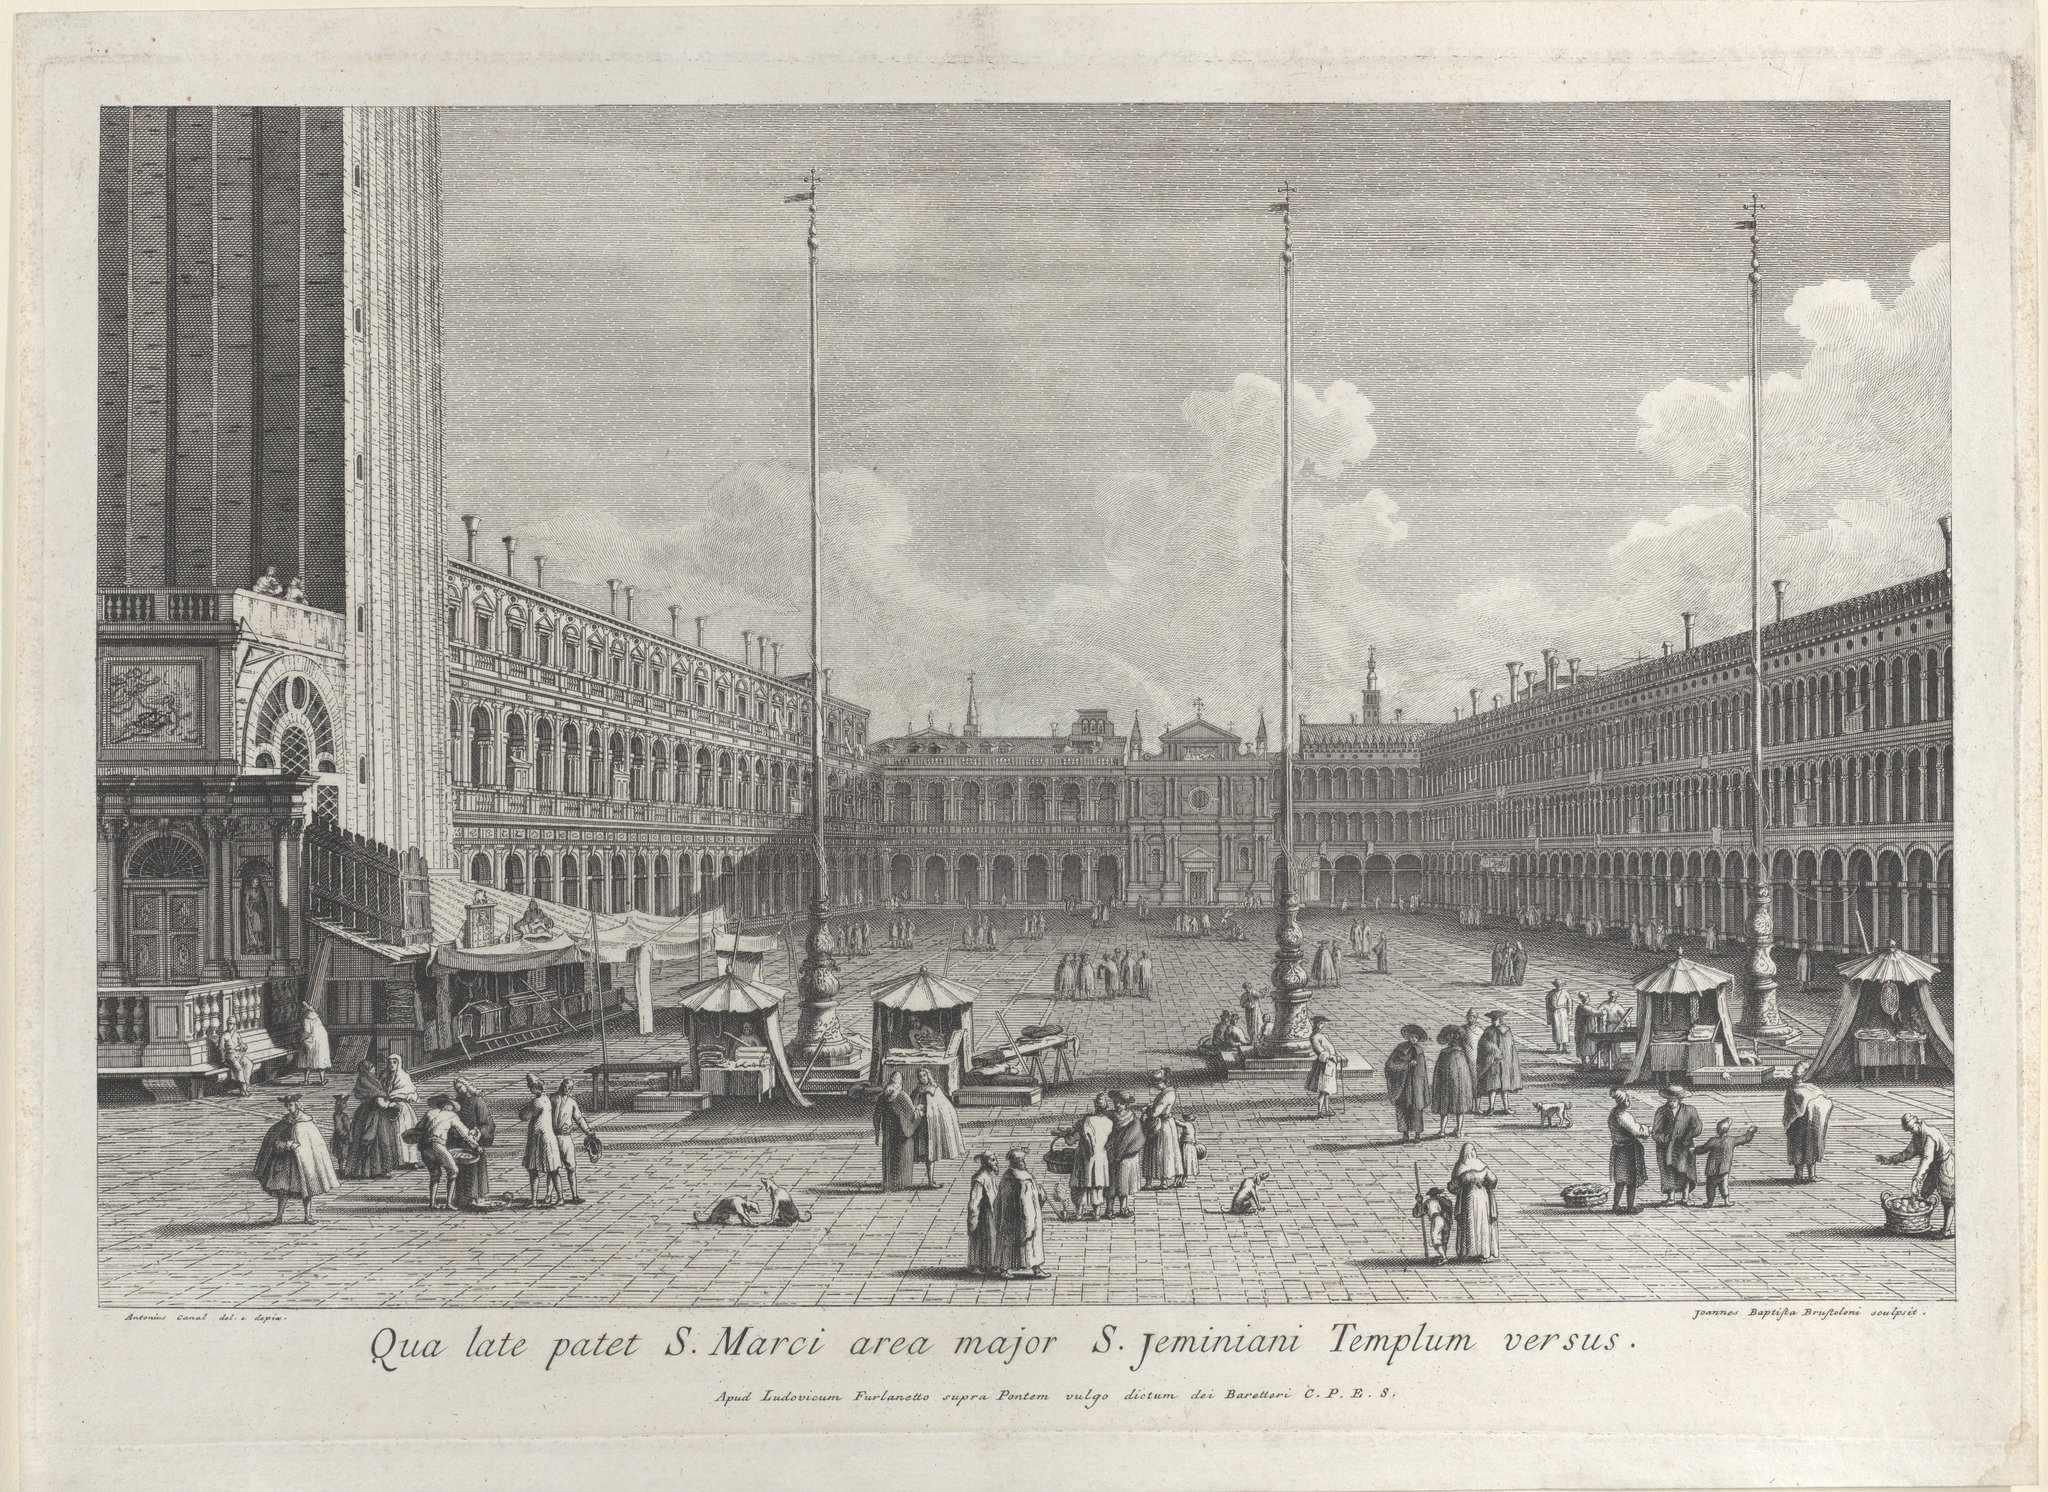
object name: print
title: View of Piazza San Marco, with the church of San Geminiano at the far end, and figures and market stalls in the foreground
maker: giovanni battista brustolon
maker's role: artist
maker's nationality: italian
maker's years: 1712-1796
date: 1763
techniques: etching